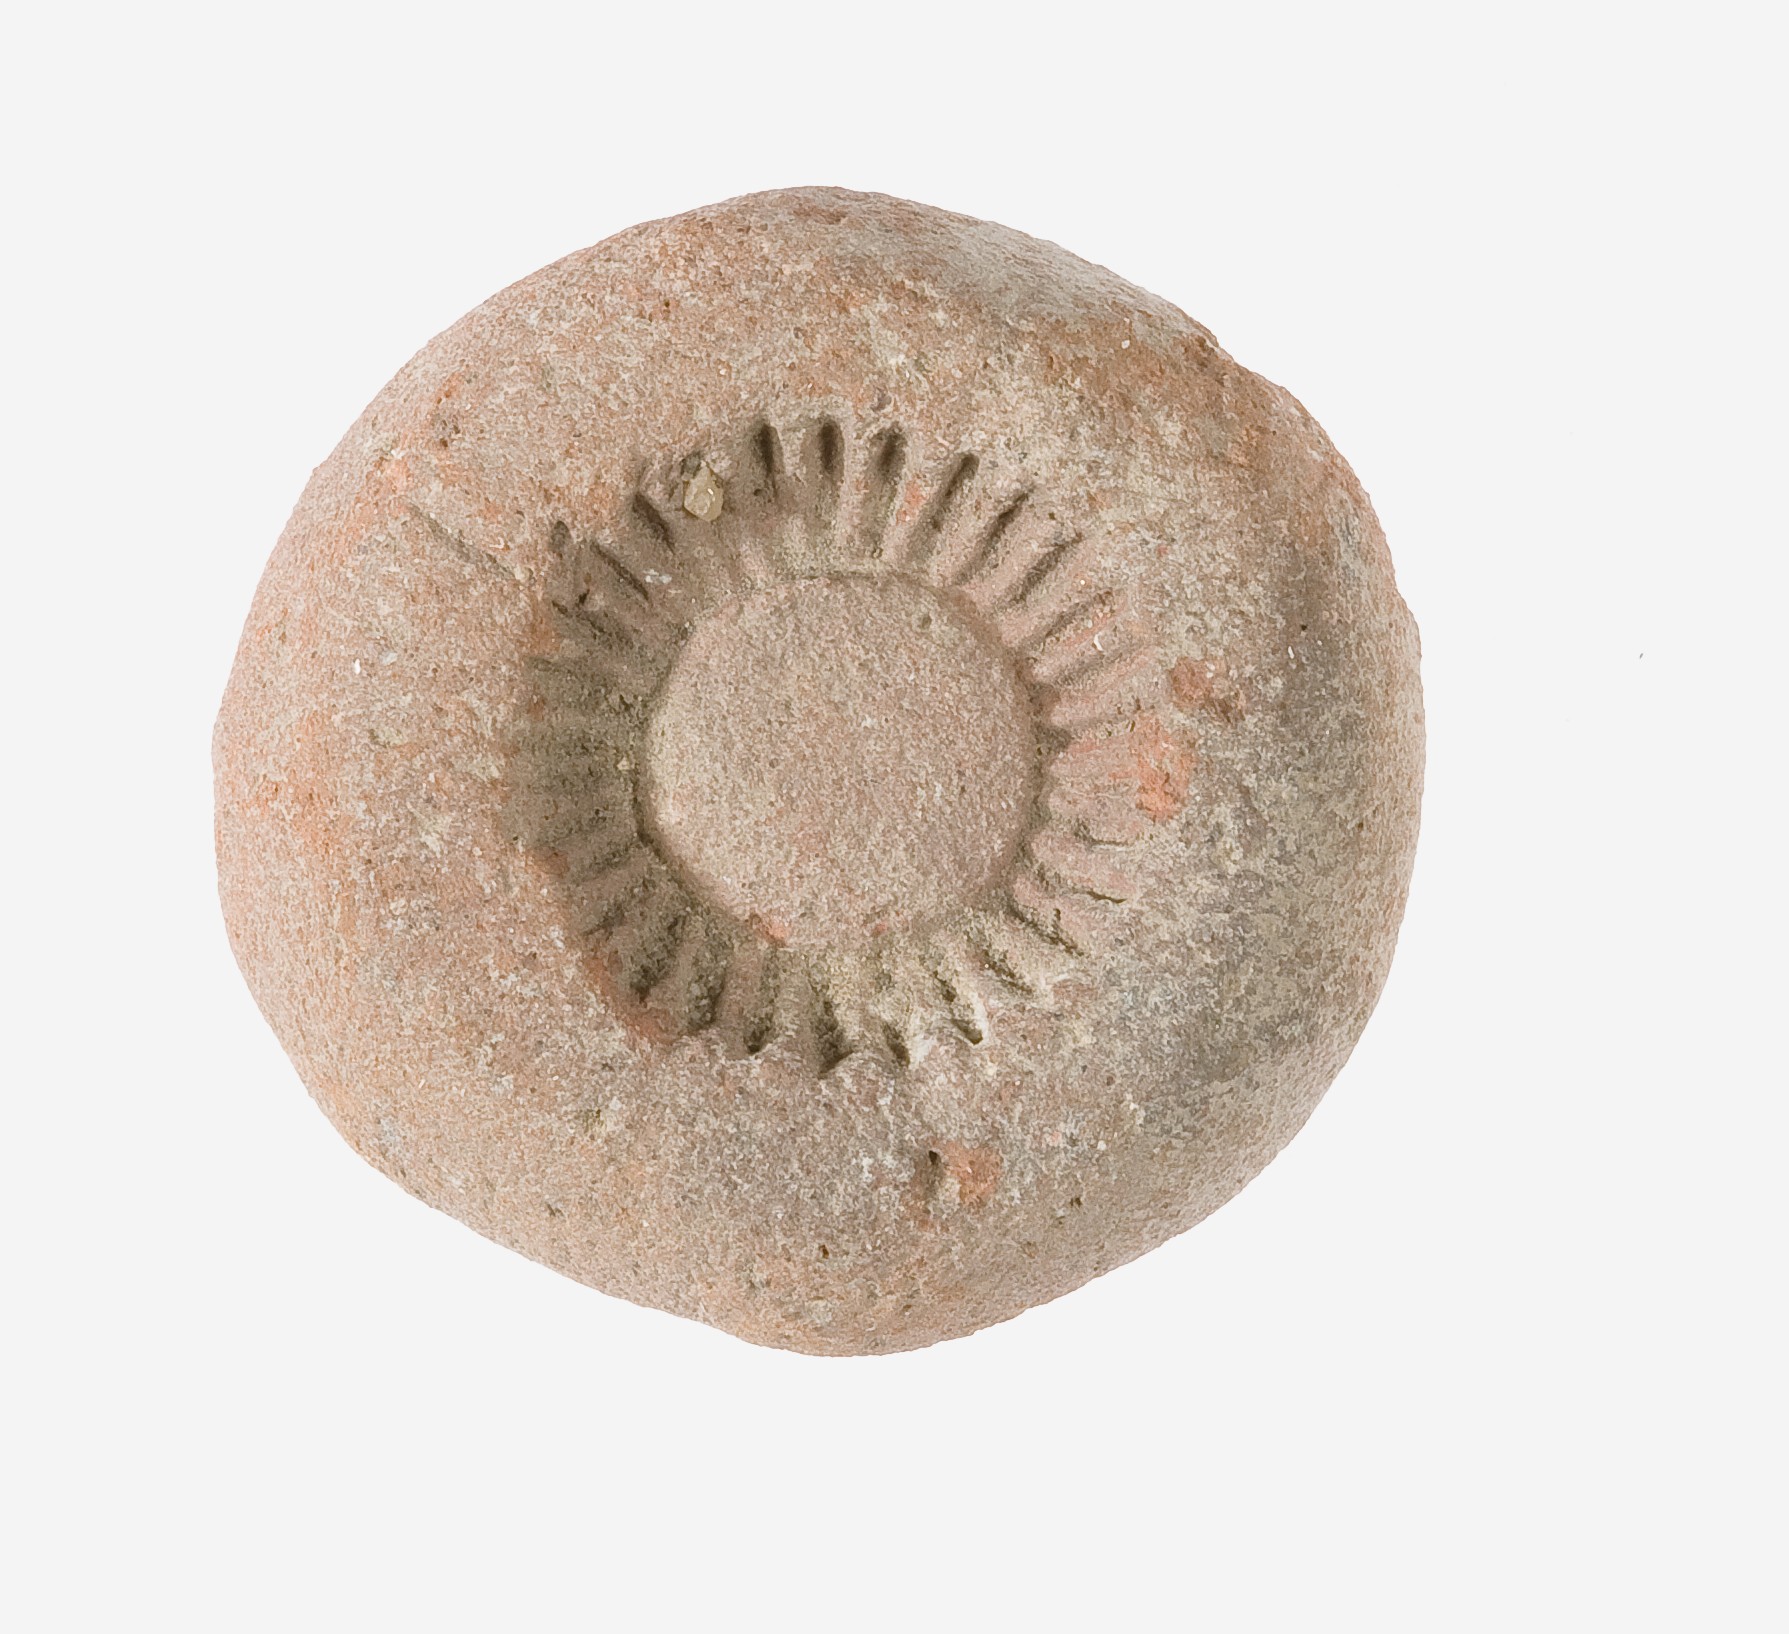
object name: mold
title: Mold for small ring ornaments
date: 1390-1352 BCE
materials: pottery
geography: egypt